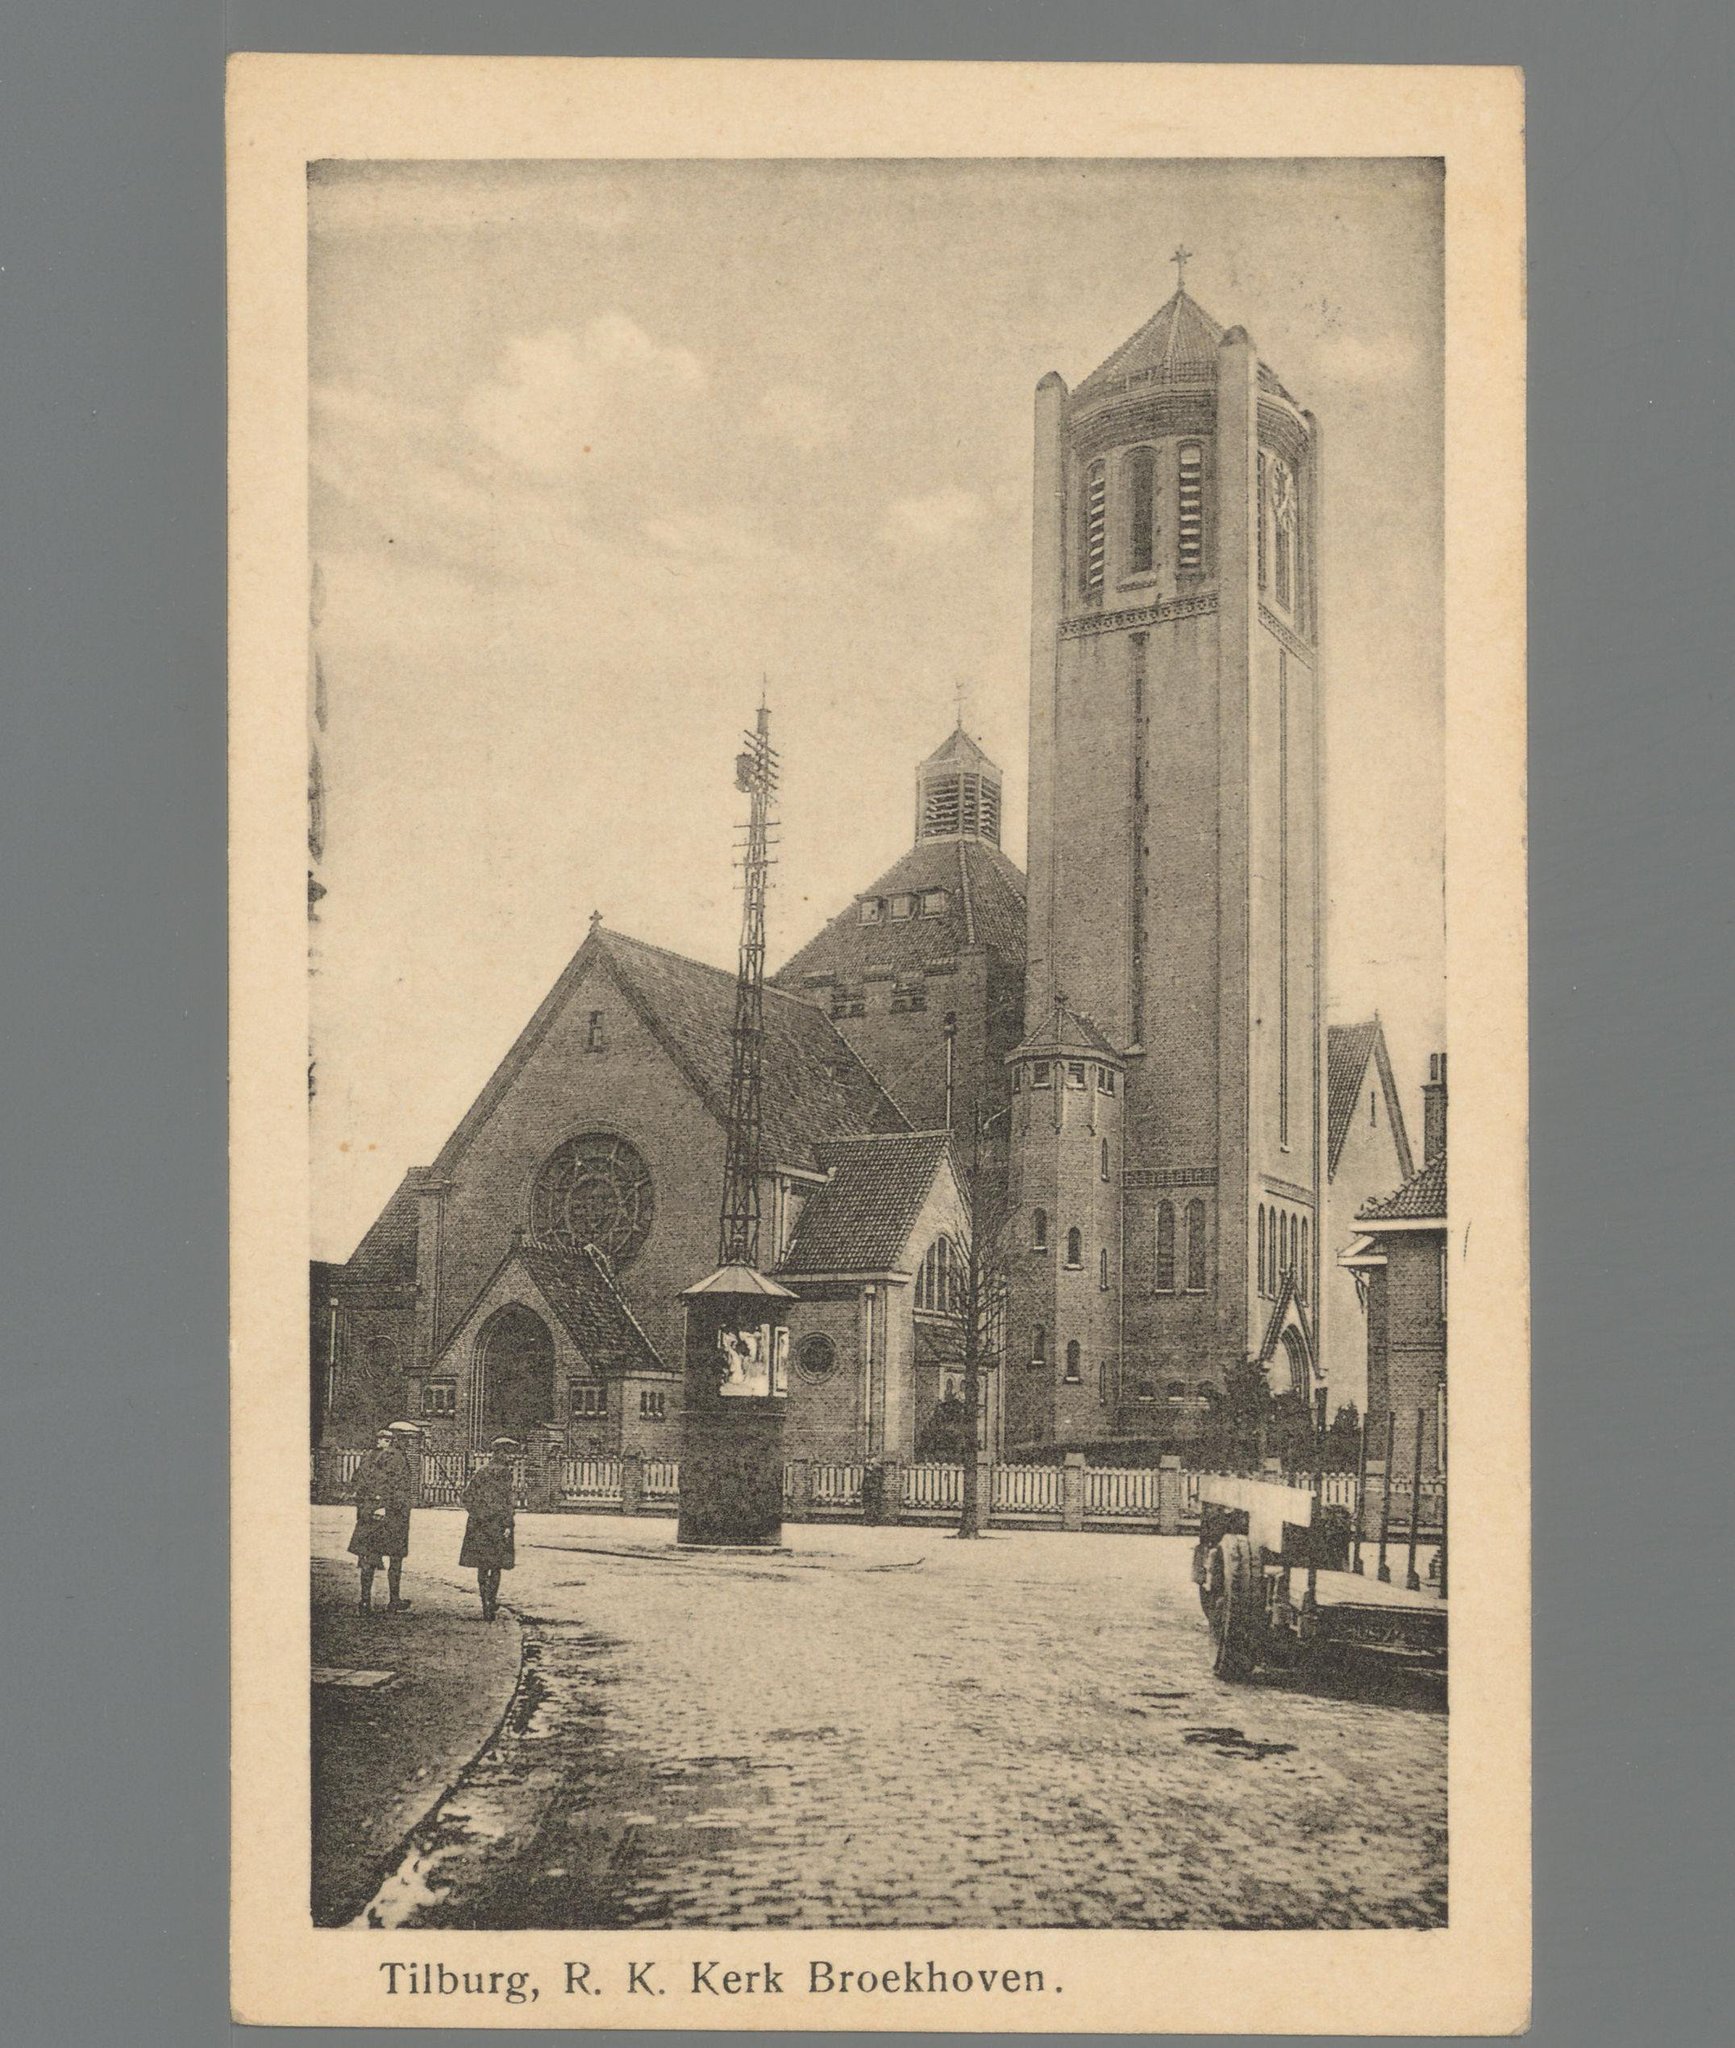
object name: photomechanical print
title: Tilburg, R. K. Kerk Broekhoven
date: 1913-1928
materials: cardboard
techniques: photograph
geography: tilburg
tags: church (exterior)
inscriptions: postage stamp